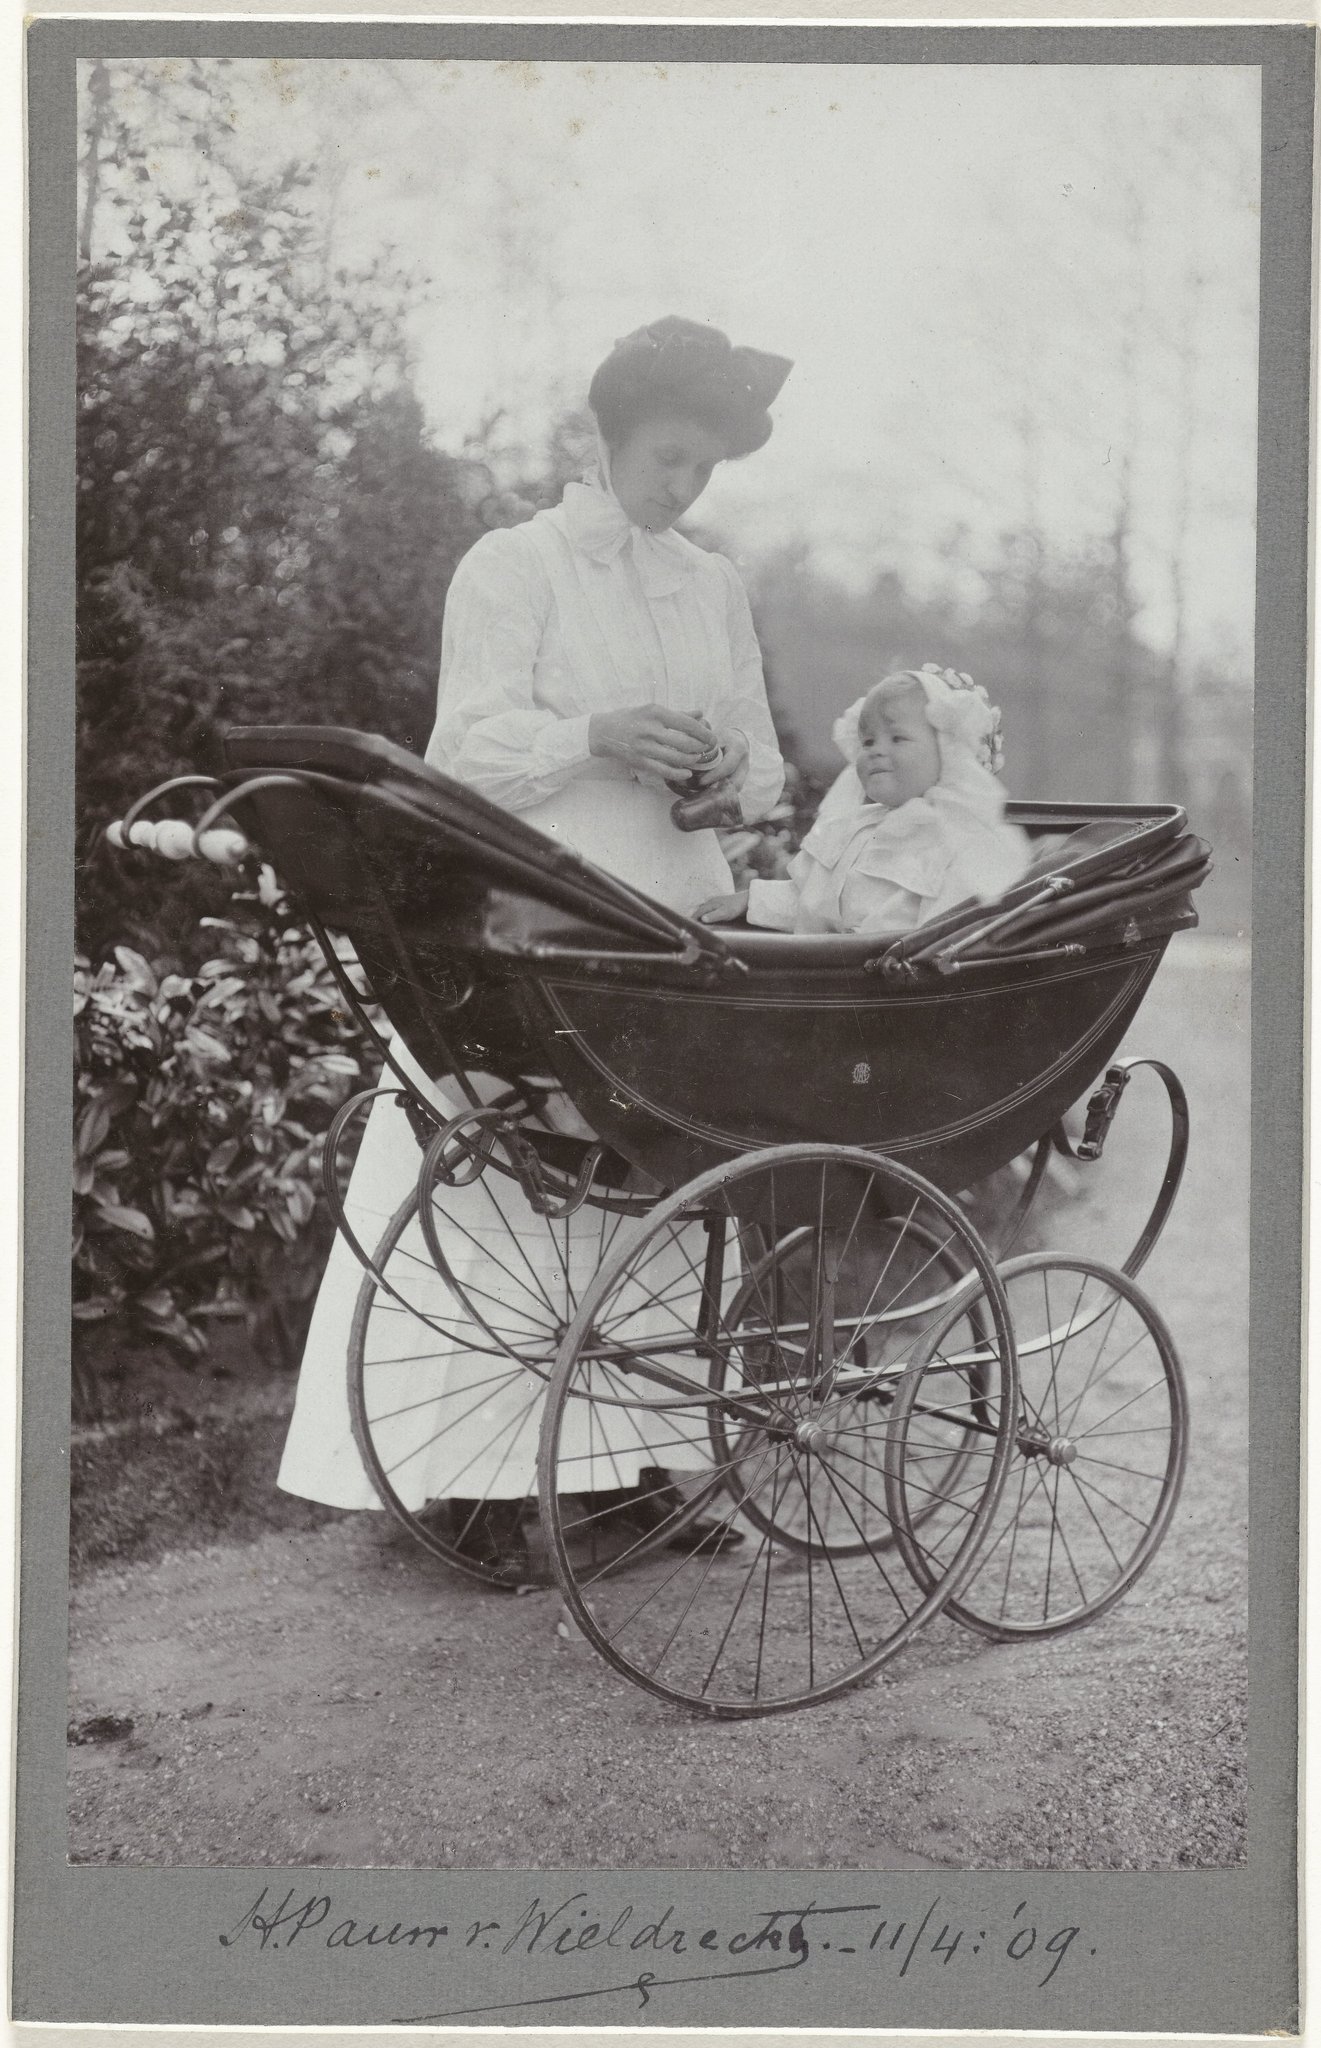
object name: photograph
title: Thelma Pauw van Wieldrecht als anderhalfjarige in een kinderwagen met daarnaast een nanny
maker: henry pauw van wieldrecht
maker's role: fotograaf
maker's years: 1863-1912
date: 1909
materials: cardboard, photographic support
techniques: collodion silver print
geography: netherlands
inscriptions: annotation: ‘No 3560 / 1909.’, annotation: ‘Nanny / Thelma / [in ptlood:] Irene’, signature and date: ‘H. Pauw v. Wieldrecht. - 11/4:'09’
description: Adriana Johanna Thelma was geboren op 18 oktober 1907